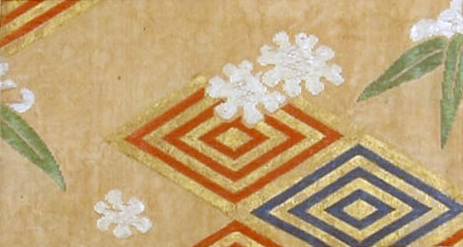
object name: piece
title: Textile with Snow, Bamboo, and Concentric Diamond Lozenges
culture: japanese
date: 1615-1868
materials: gold leaf, silk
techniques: brocade, weave